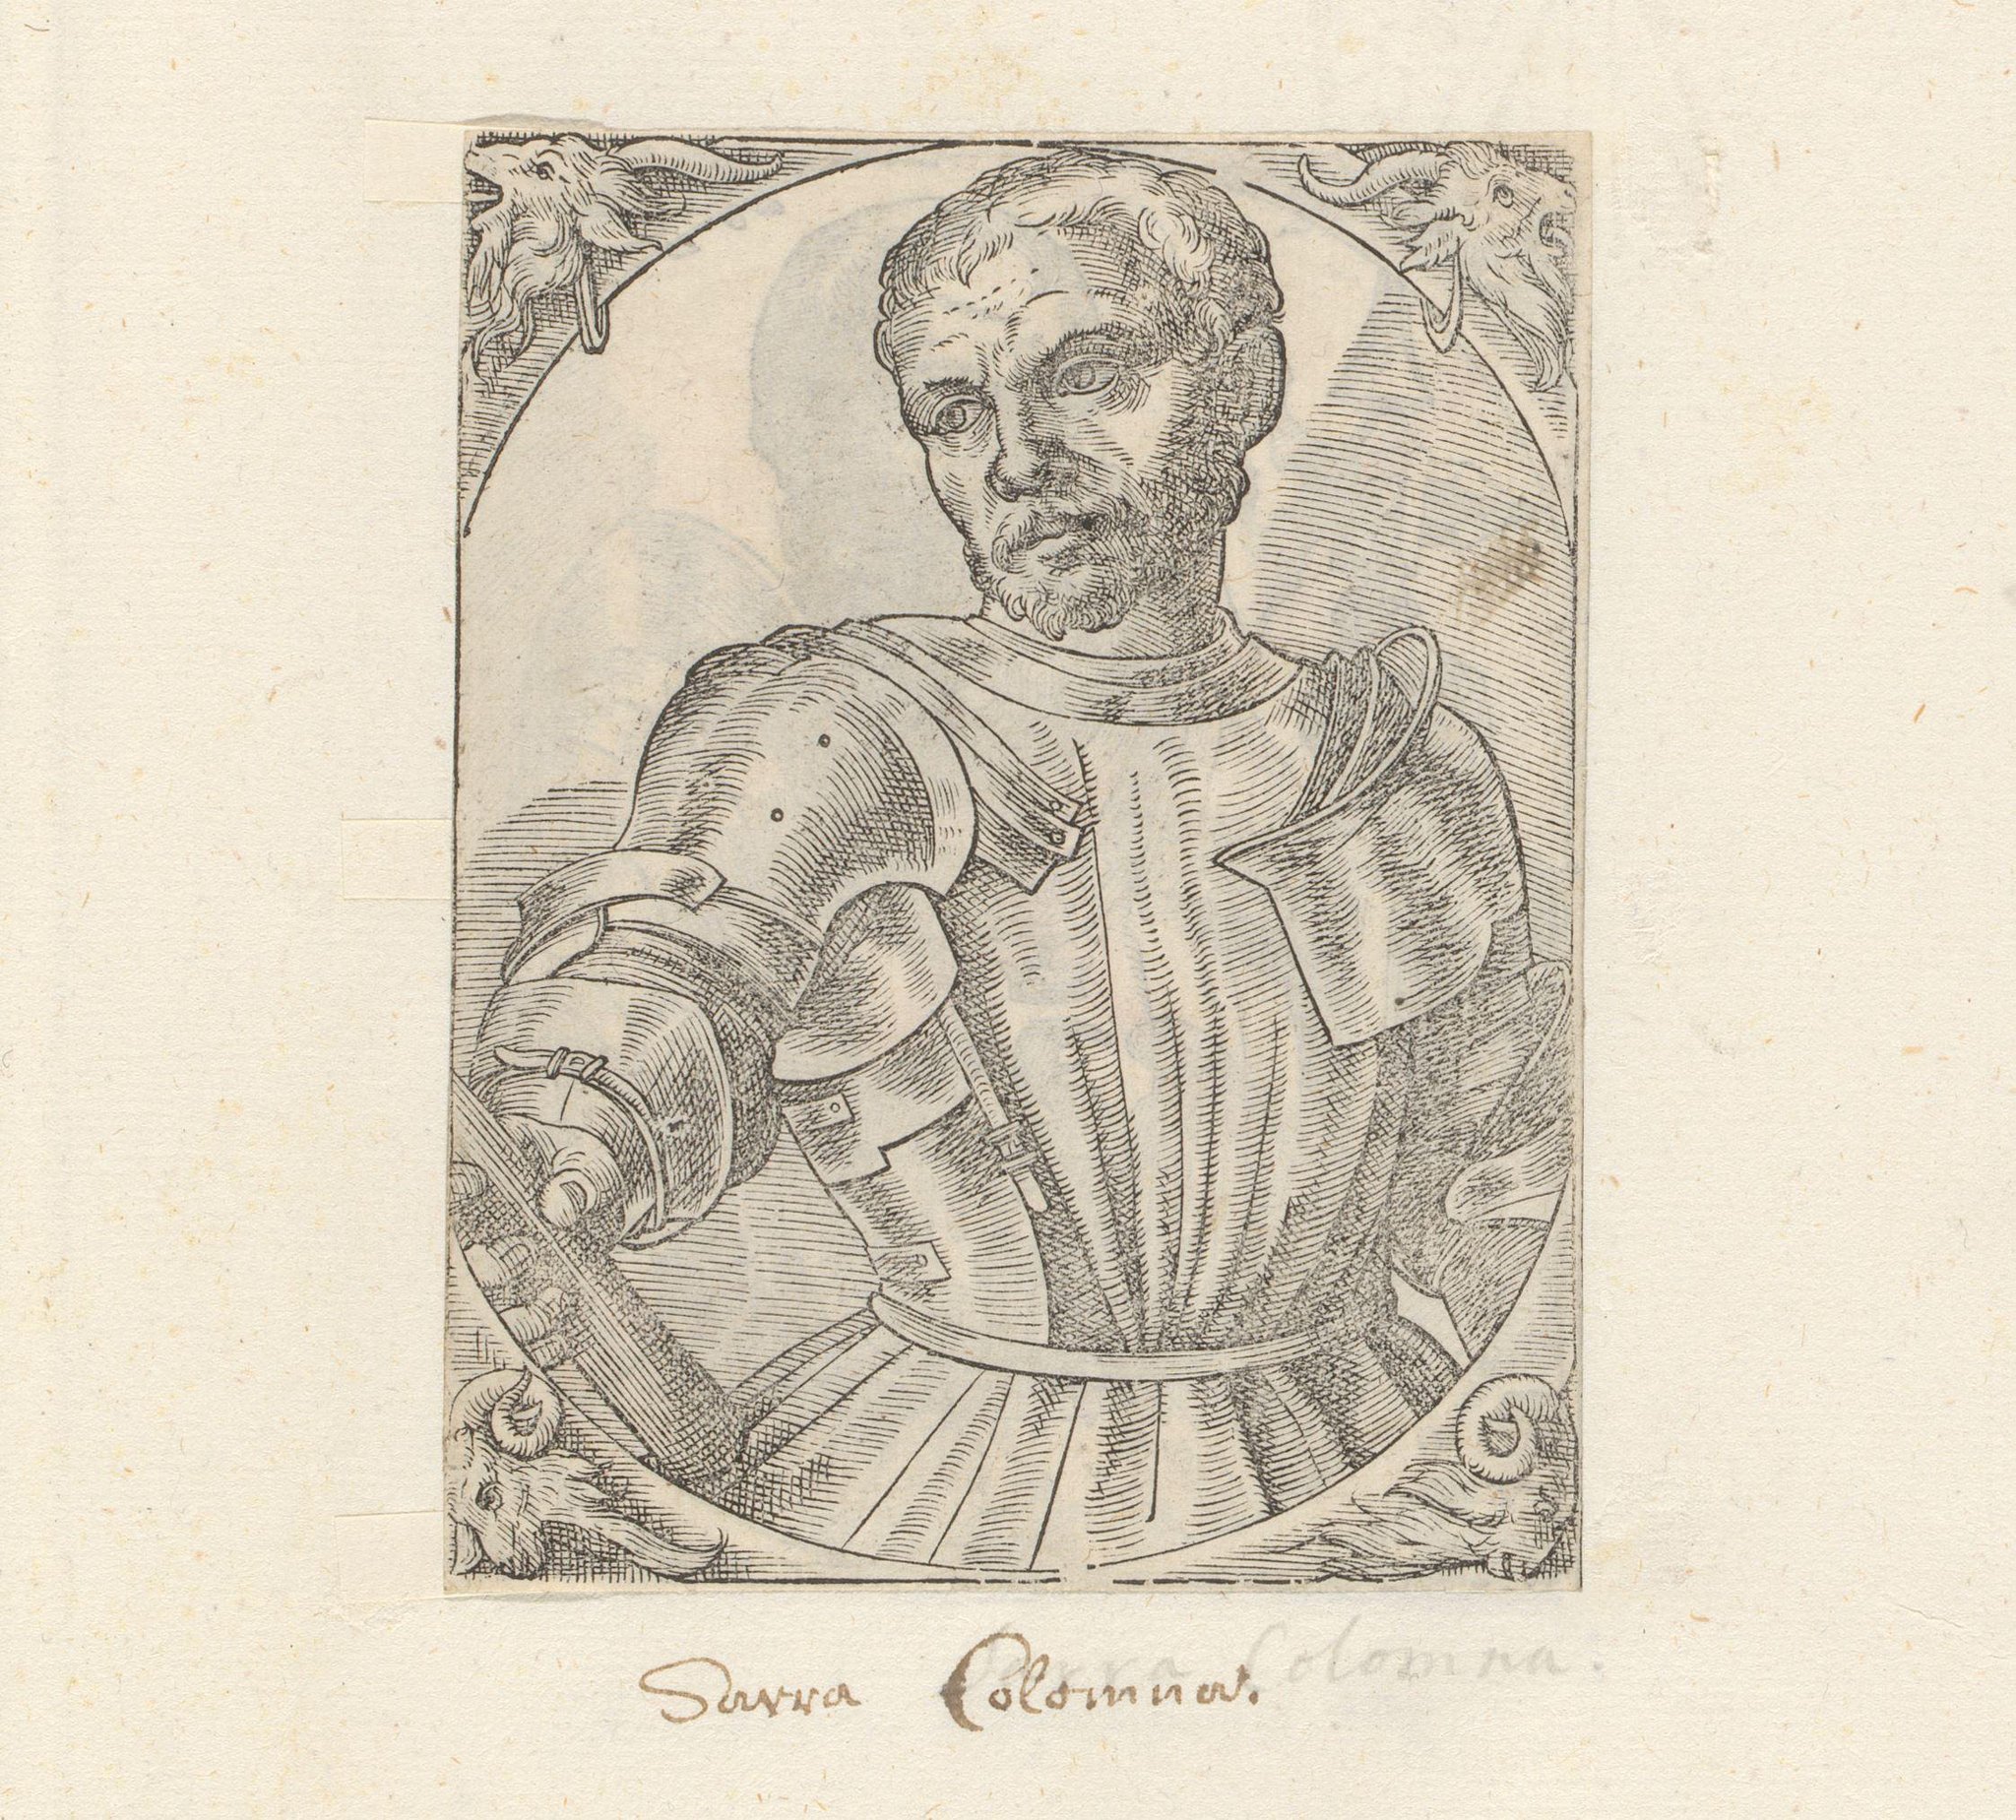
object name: book illustration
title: Portret van Columna Sarra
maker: Anonymous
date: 1549-1575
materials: paper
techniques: woodcut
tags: historical persons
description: Prent gebruikt in: Giovio, Paolo. Elogia Virorum bellica virtute illustrium (...). Bazel: Peter Perna, 1575.